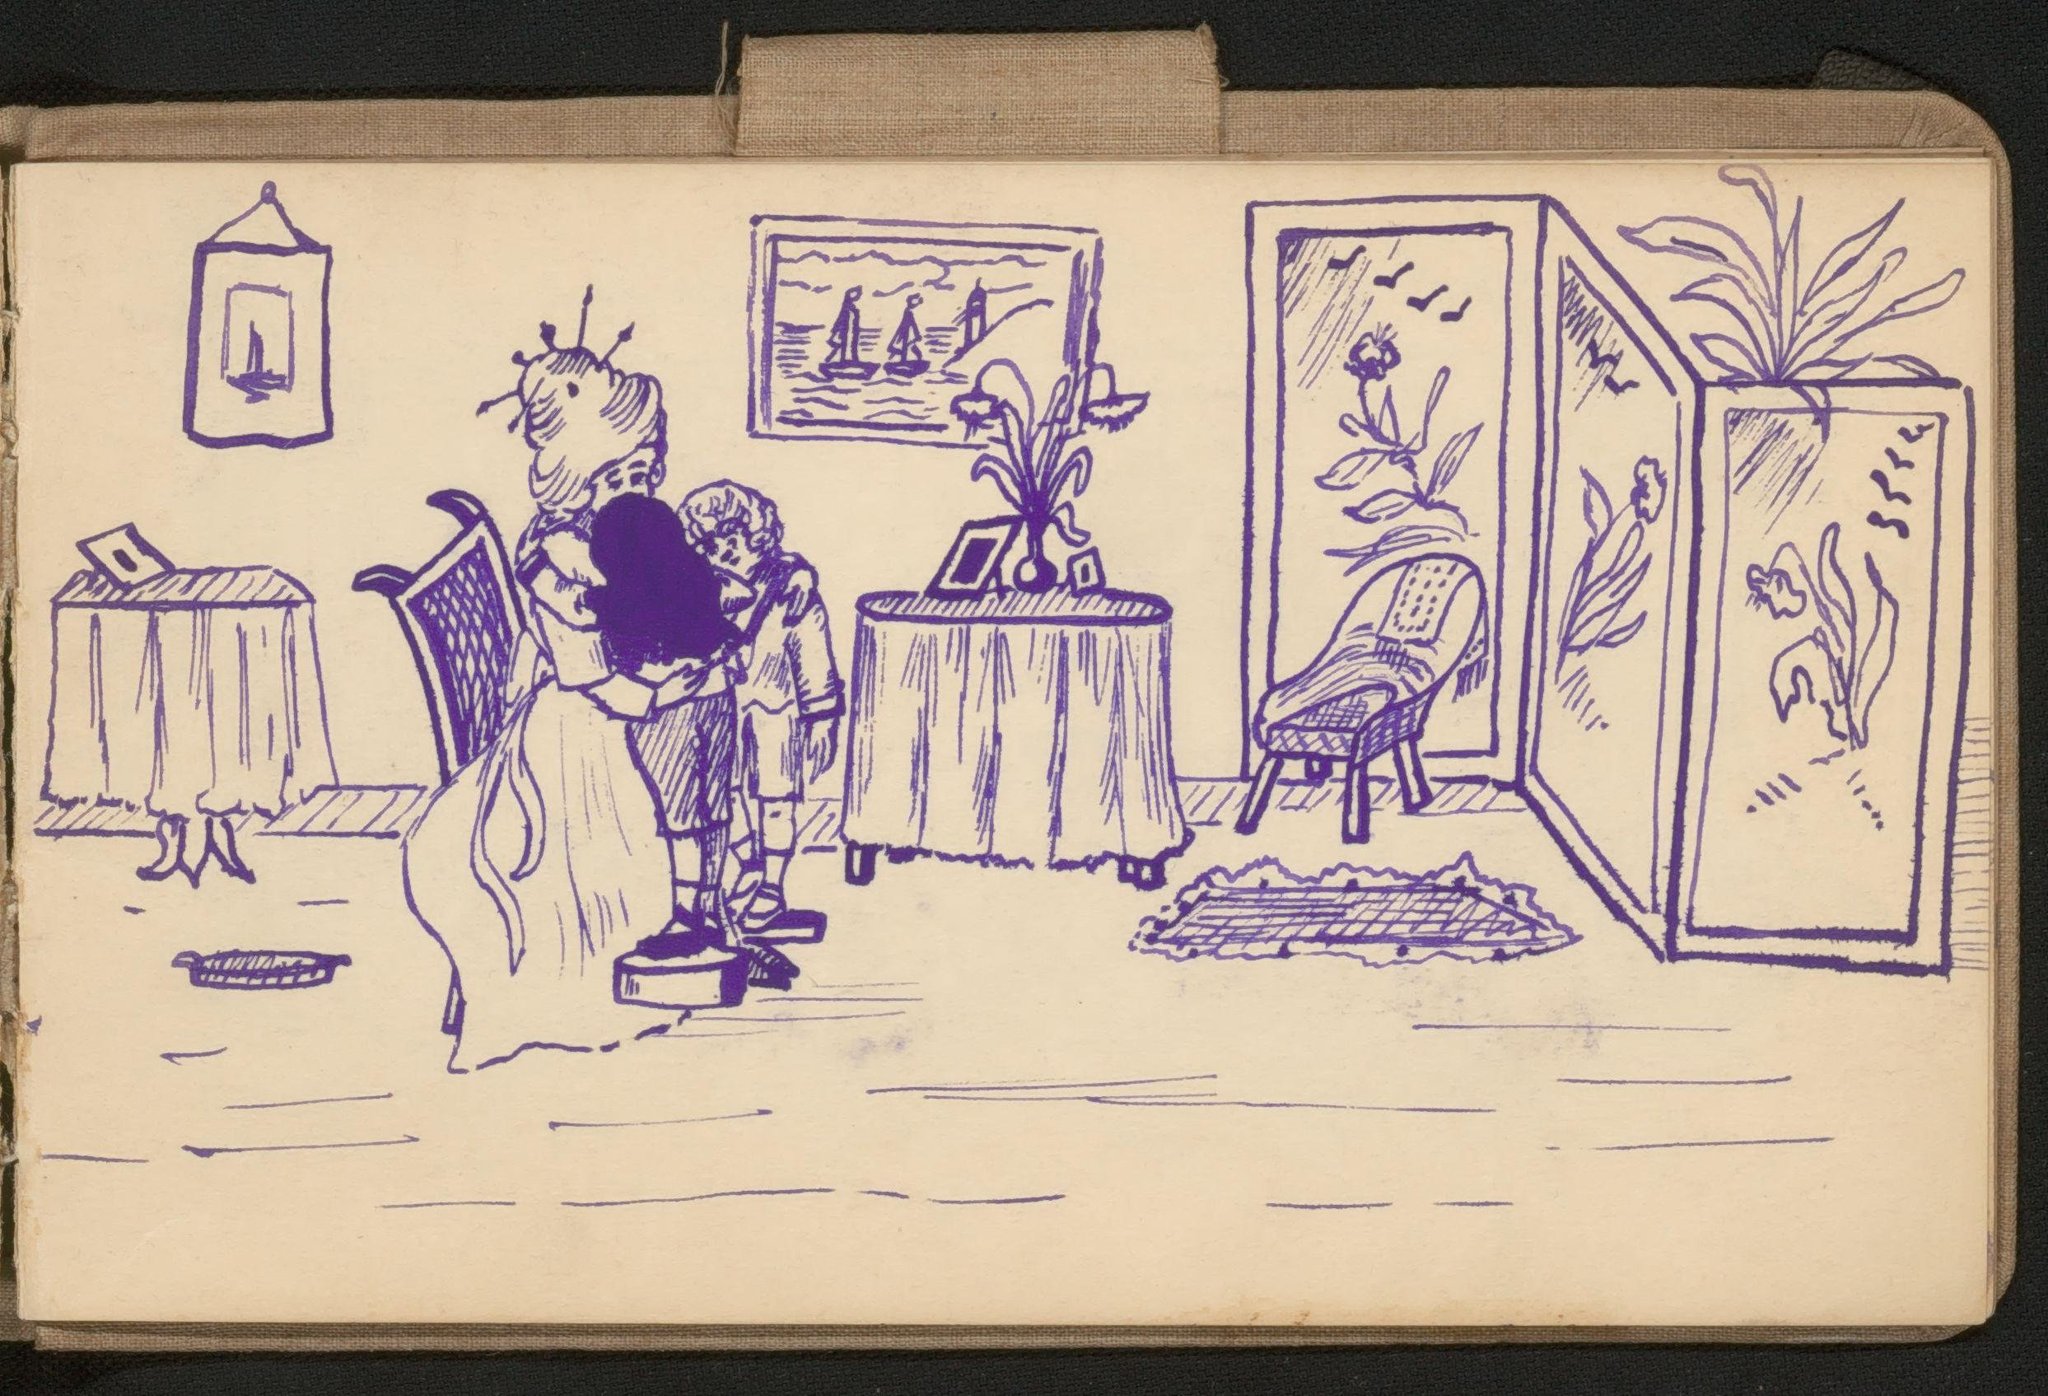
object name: sketchbook leaf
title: Moeder troost de snoepers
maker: Anonymous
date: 1875-1920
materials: ink, paper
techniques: pen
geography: netherlands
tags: mischief-making play, correction of naughty children, the naughty child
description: Moeder neemt de twee kinderen in de armen na hun straf. Onderdeel van het schetsboek met humoristische tekeningen over het leven van een 'famille nombreuse'. Onderwerpsrubrieken binnen de Atlas Zeden en Gewoonten: Zeden en Gewoonten in Engeren Zin, Des menschen beging, midden en einde, Kinderleven.